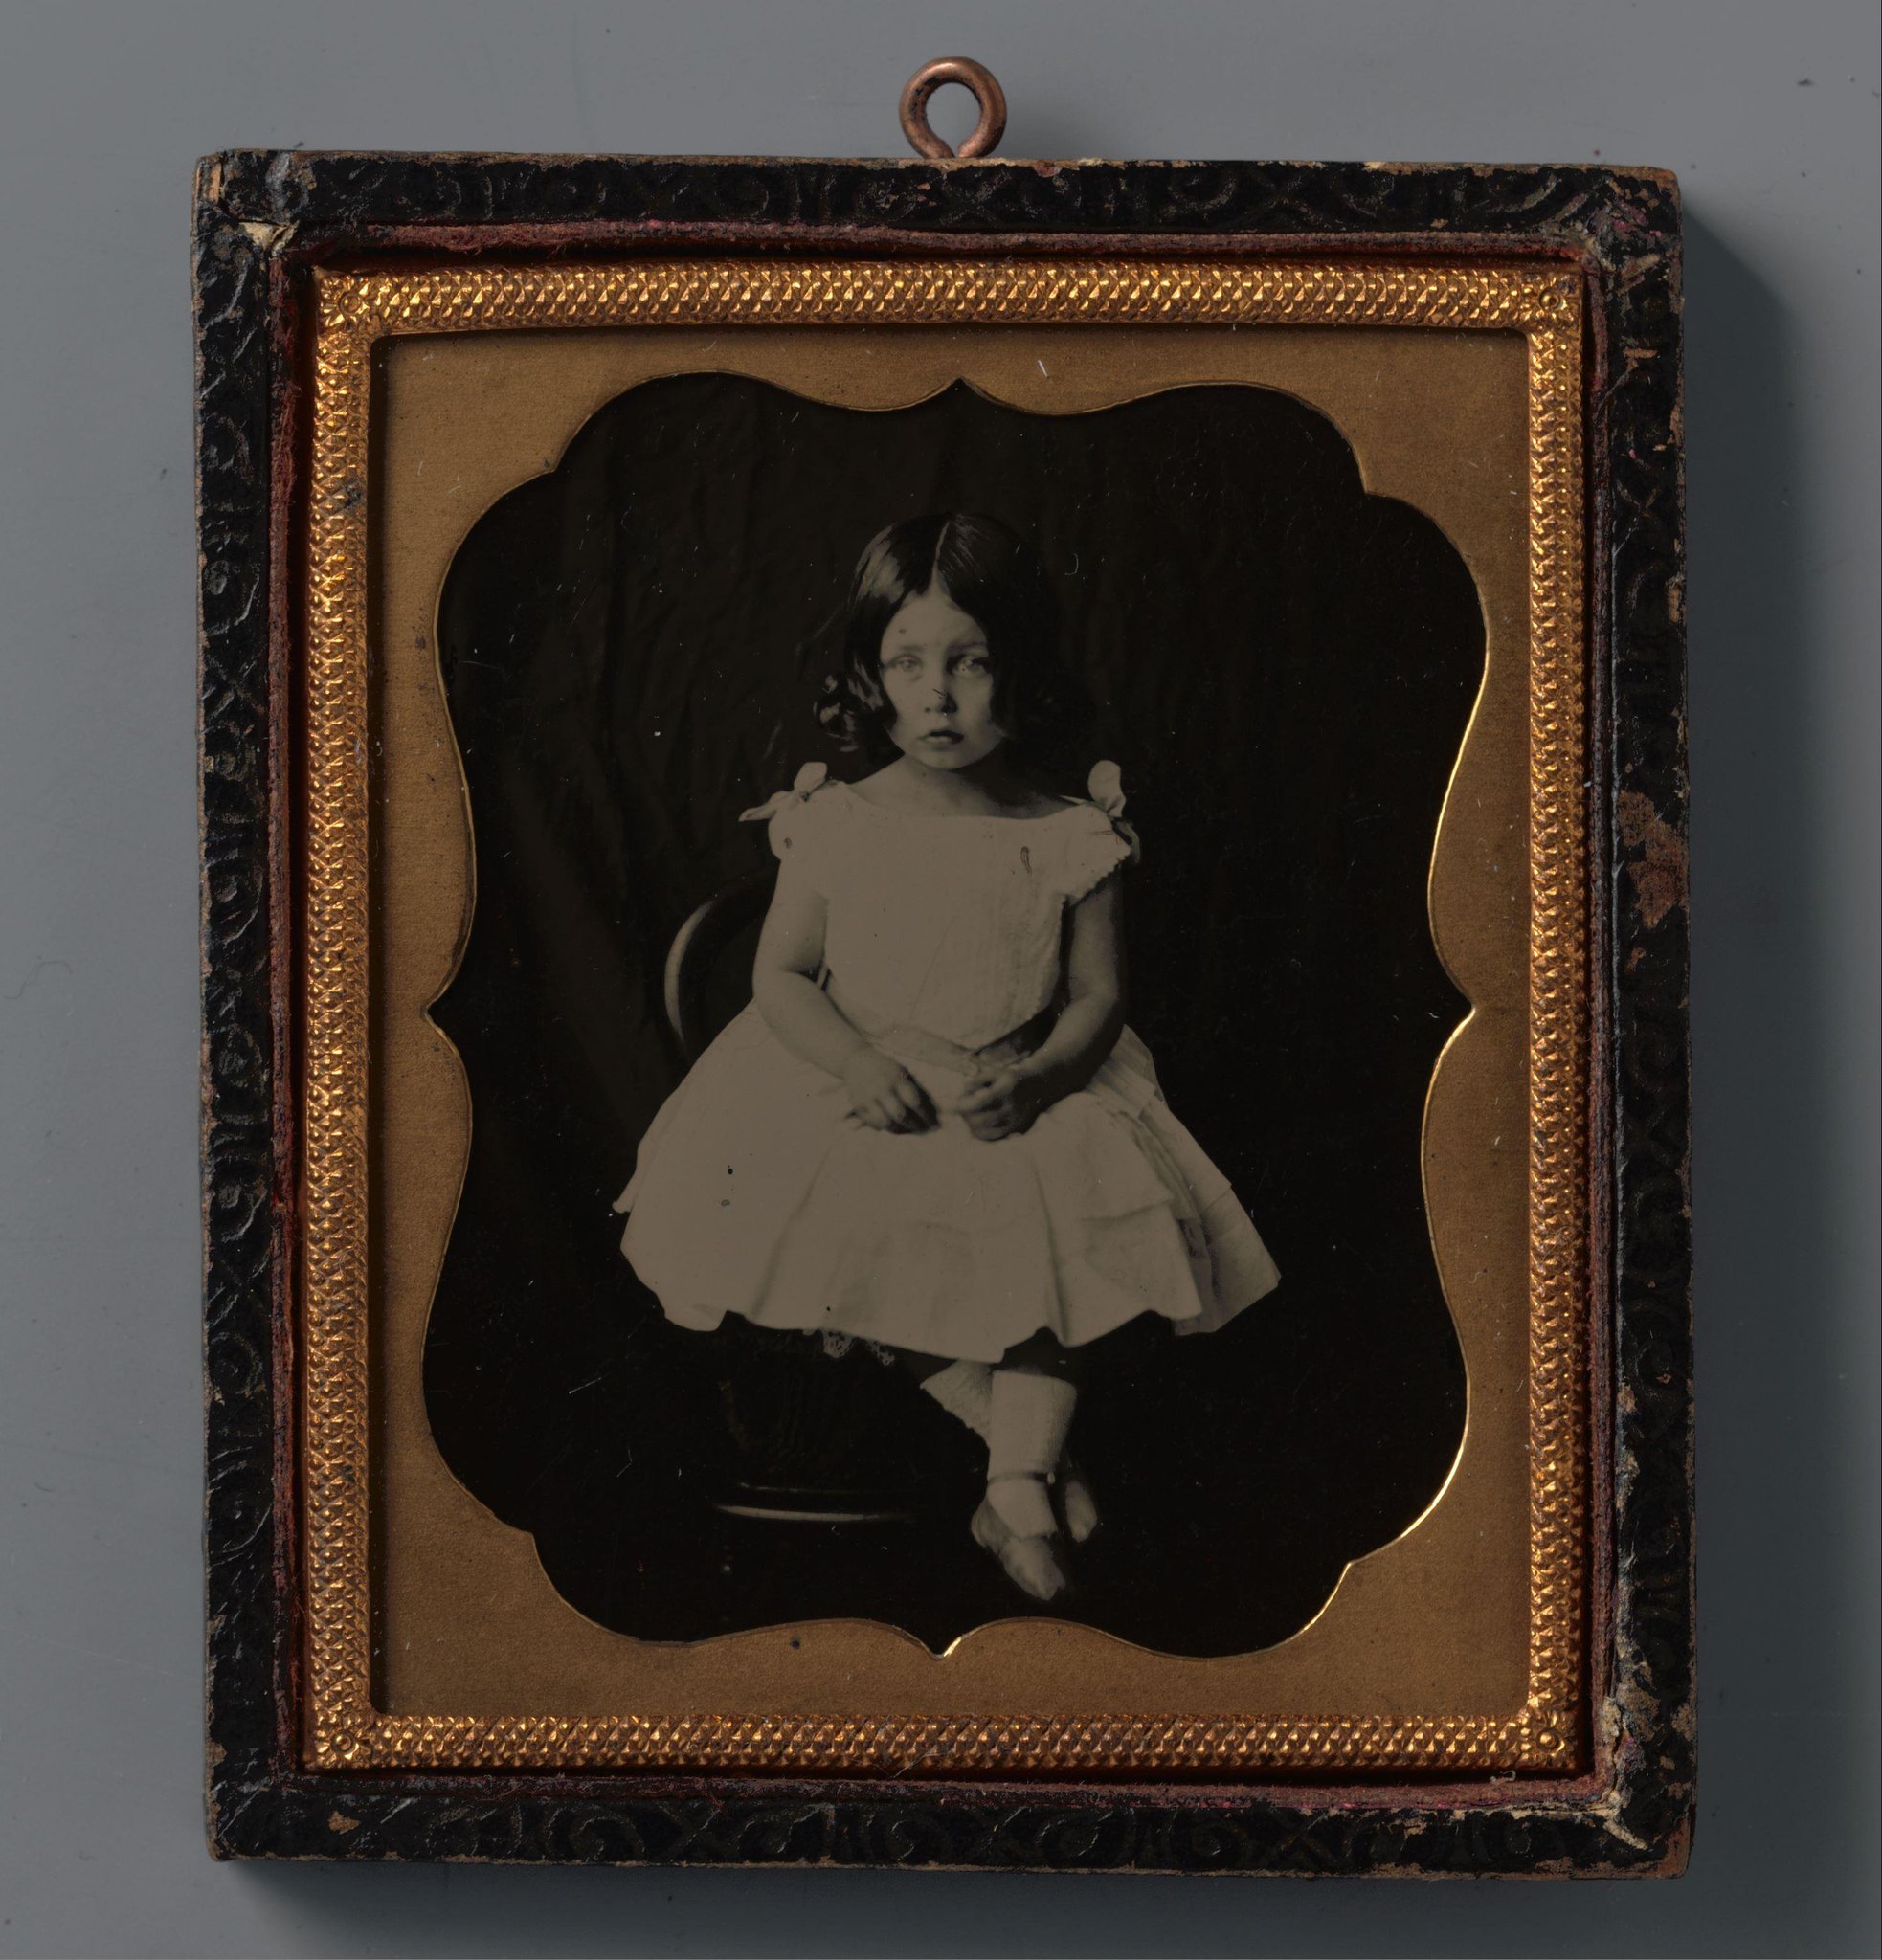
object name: frame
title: Portret van een onbekend zittend meisje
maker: Anonymous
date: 1855-1870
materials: glass, metal, paper, textile, wood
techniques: ambrotype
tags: sitting figure - aa - female human figure, historical persons - bb - woman, girl (child between toddler and youth)